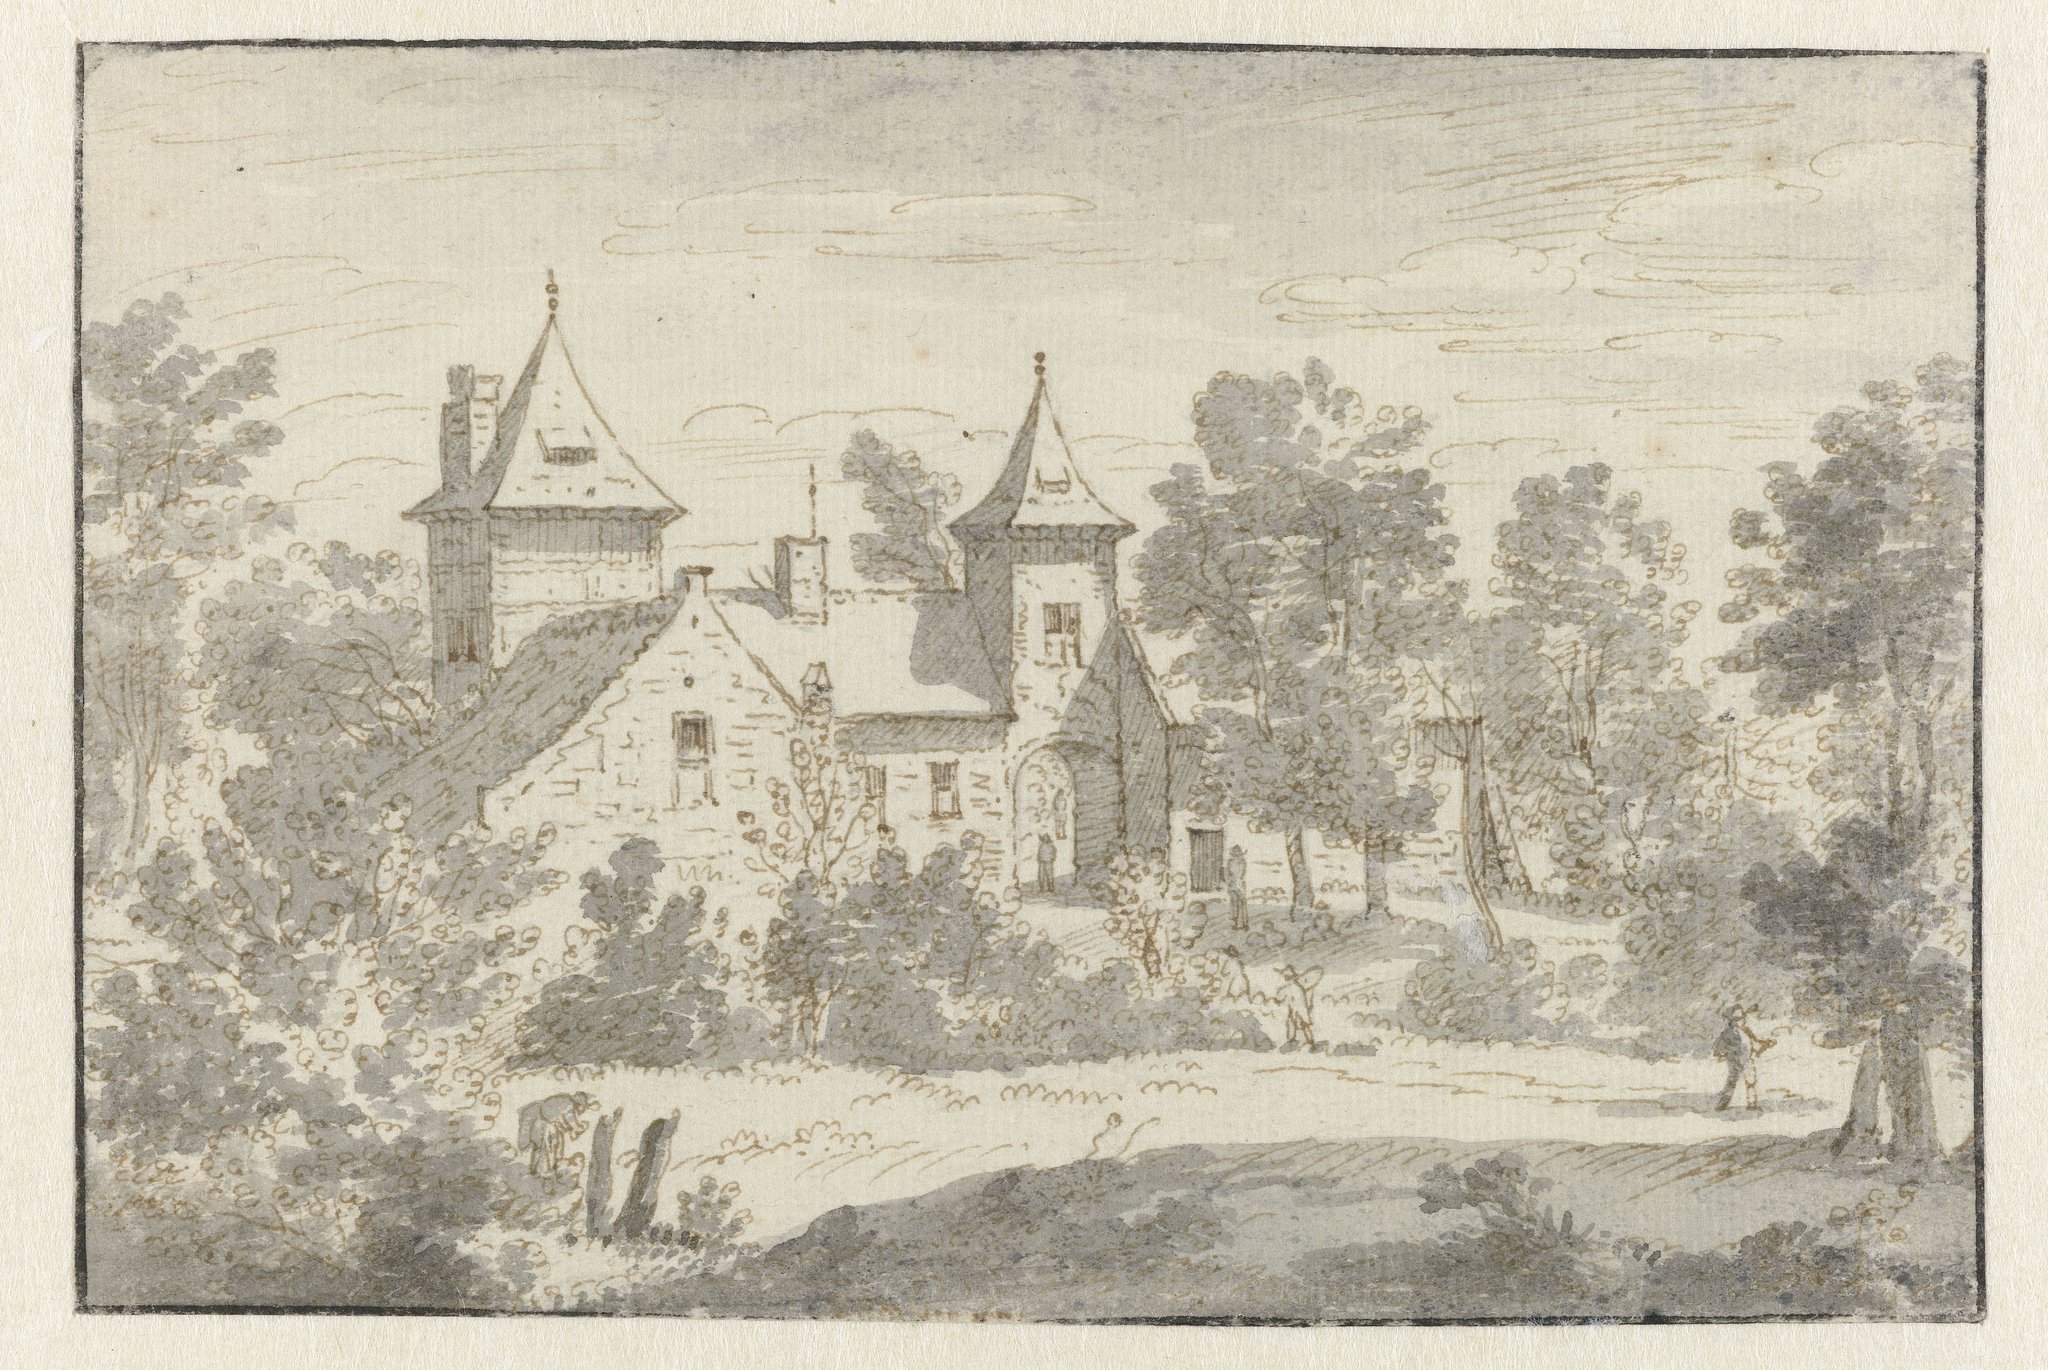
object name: drawing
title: View of Huis Pot at Nivelles, Walloon Brabant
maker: josua de grave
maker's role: draughtsman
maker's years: 1645-1712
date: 1676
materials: ink, paper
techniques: brush, pen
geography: nivelles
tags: rural housing, e.g. country-house, villa, cottage, farm or solitary house in landscape